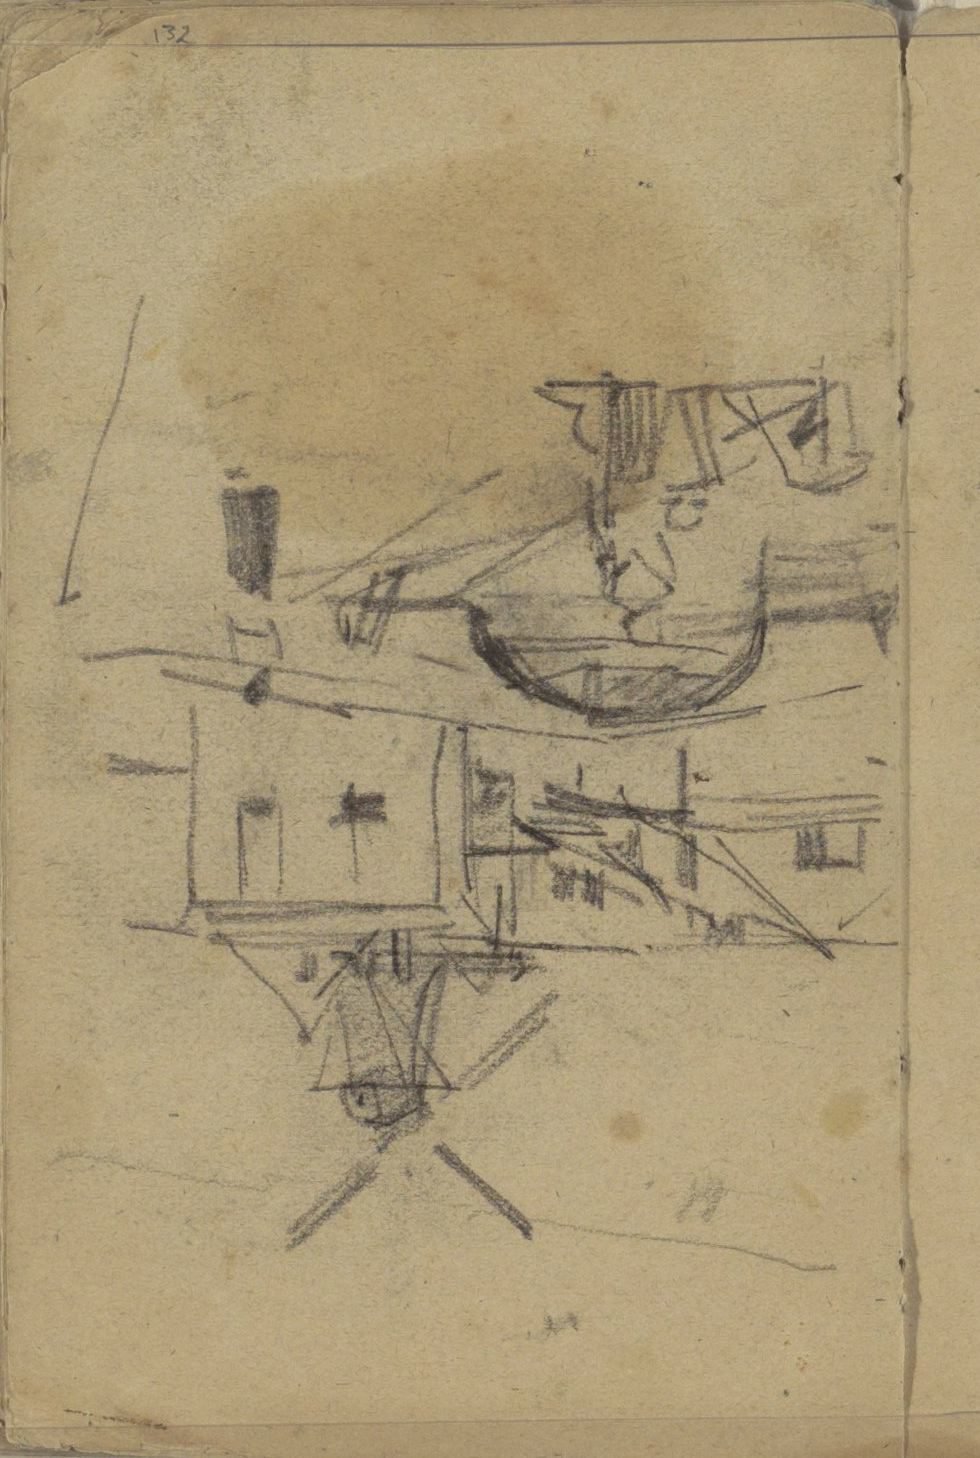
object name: sketchbook leaf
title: Stadsgezicht met een molen, mogelijk Delft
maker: george hendrik breitner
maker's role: draughtsman, painter, print maker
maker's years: 1857-1923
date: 1881-1883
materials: chalk, paper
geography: delft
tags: bridge in city across river, canal, etc., windmill, city-view, and landscape with man-made constructions (+ city(-scape) with figures, staffage), delft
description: Stadsgezicht met een molen en een brug, mogelijk Delft. Vooraan figuren op de kade. Pagina 132 uit een schetsboek met 70 bladen.